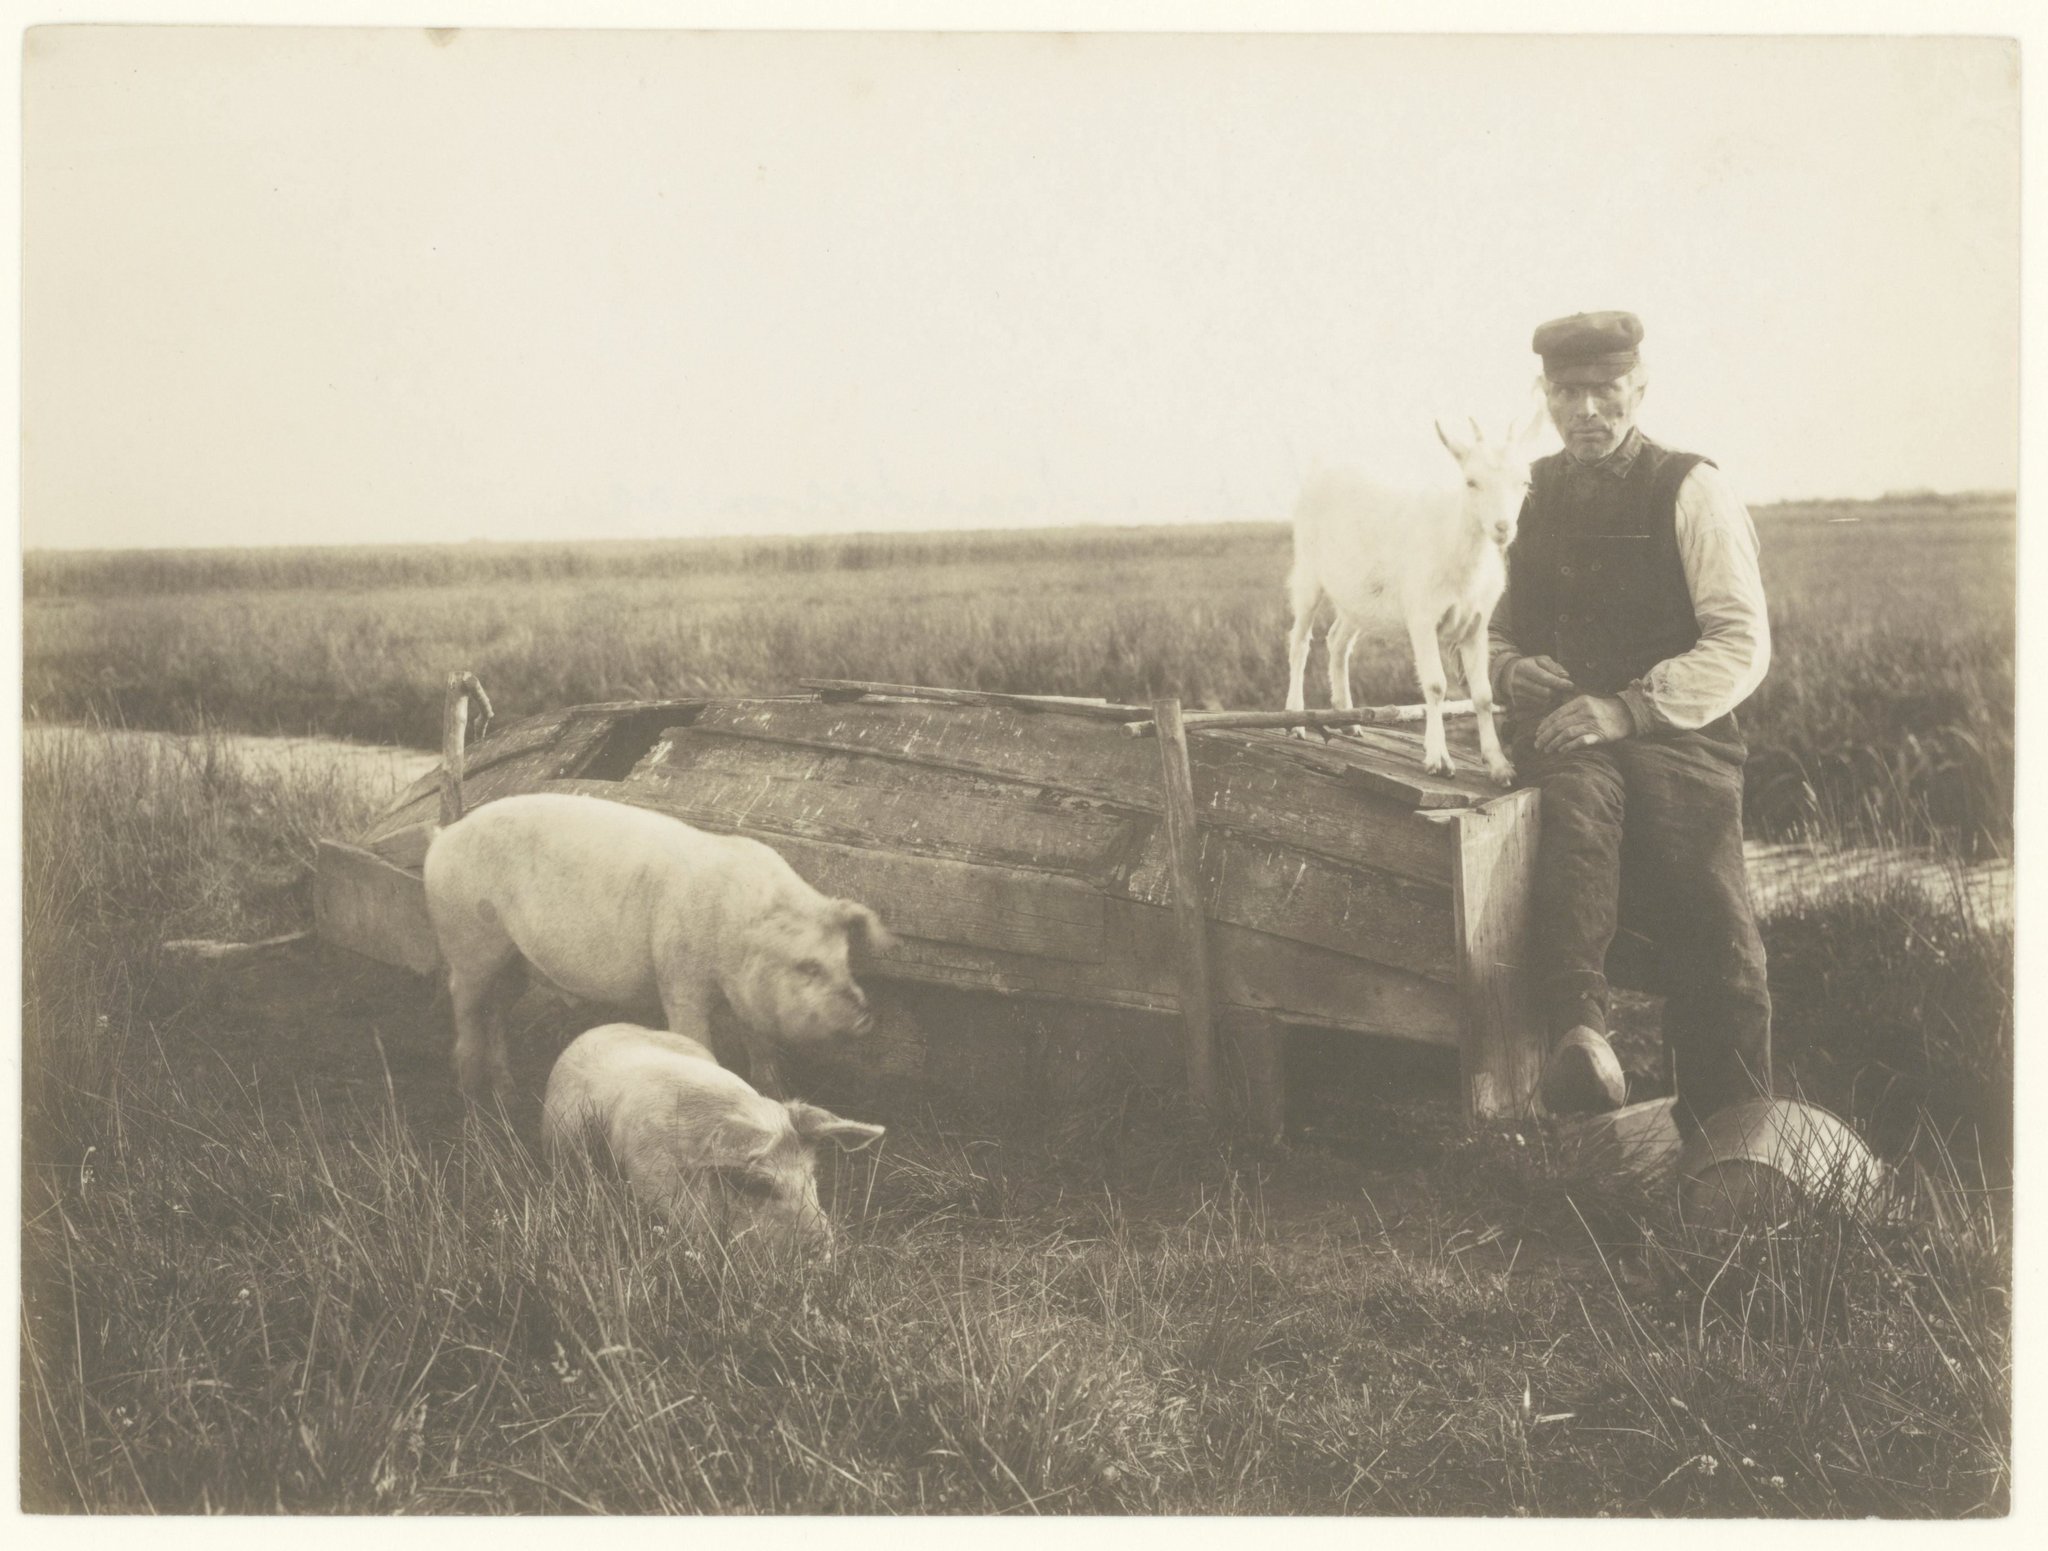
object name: photograph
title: Bij het Naardermeer Schweine (...) und ihr Hüter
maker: richard tepe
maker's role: fotograaf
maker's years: 1864-1952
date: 1906-1908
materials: paper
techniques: gelatin silver print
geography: netherlands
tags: pig, herding, herdsman, herdswoman, shepherd, shepherdess, cowherd, etc.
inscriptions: annotation: ‘Bij het Naardermeer Schweine [...] und ihr Hüter’, signature: ‘foto R Tepe’